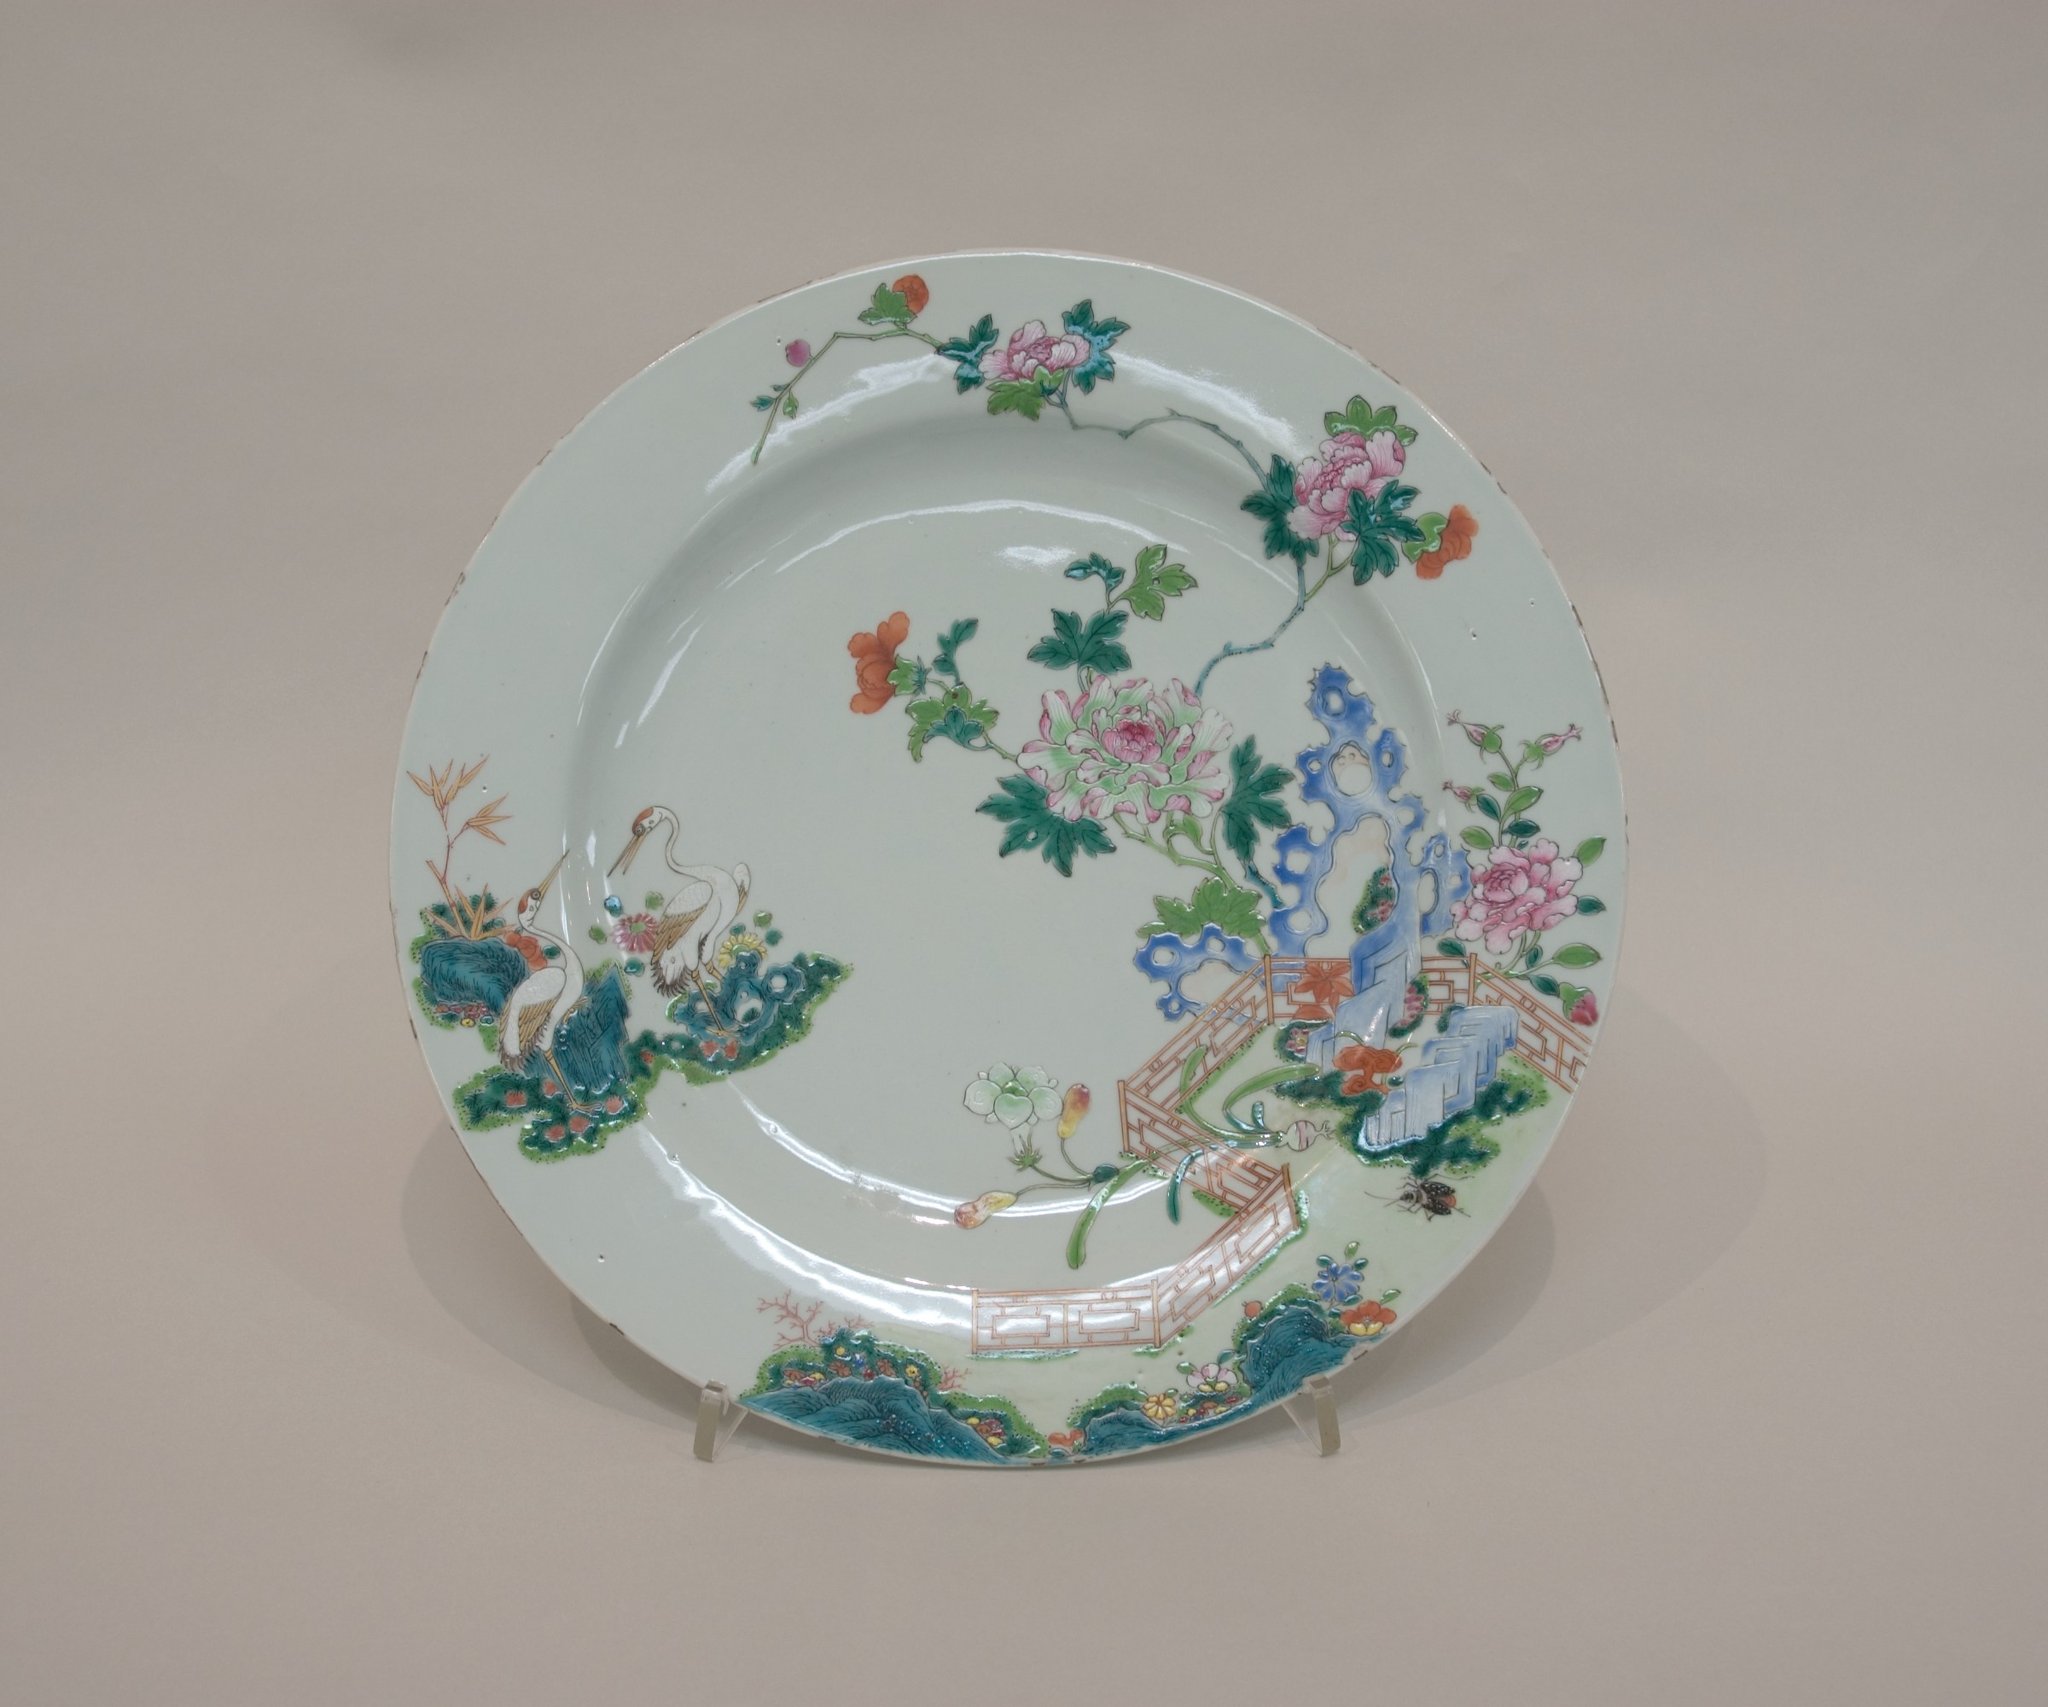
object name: plate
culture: chinese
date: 1736-1795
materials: enamel, porcelain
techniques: overglaze, painting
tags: birds,flowers,leaves